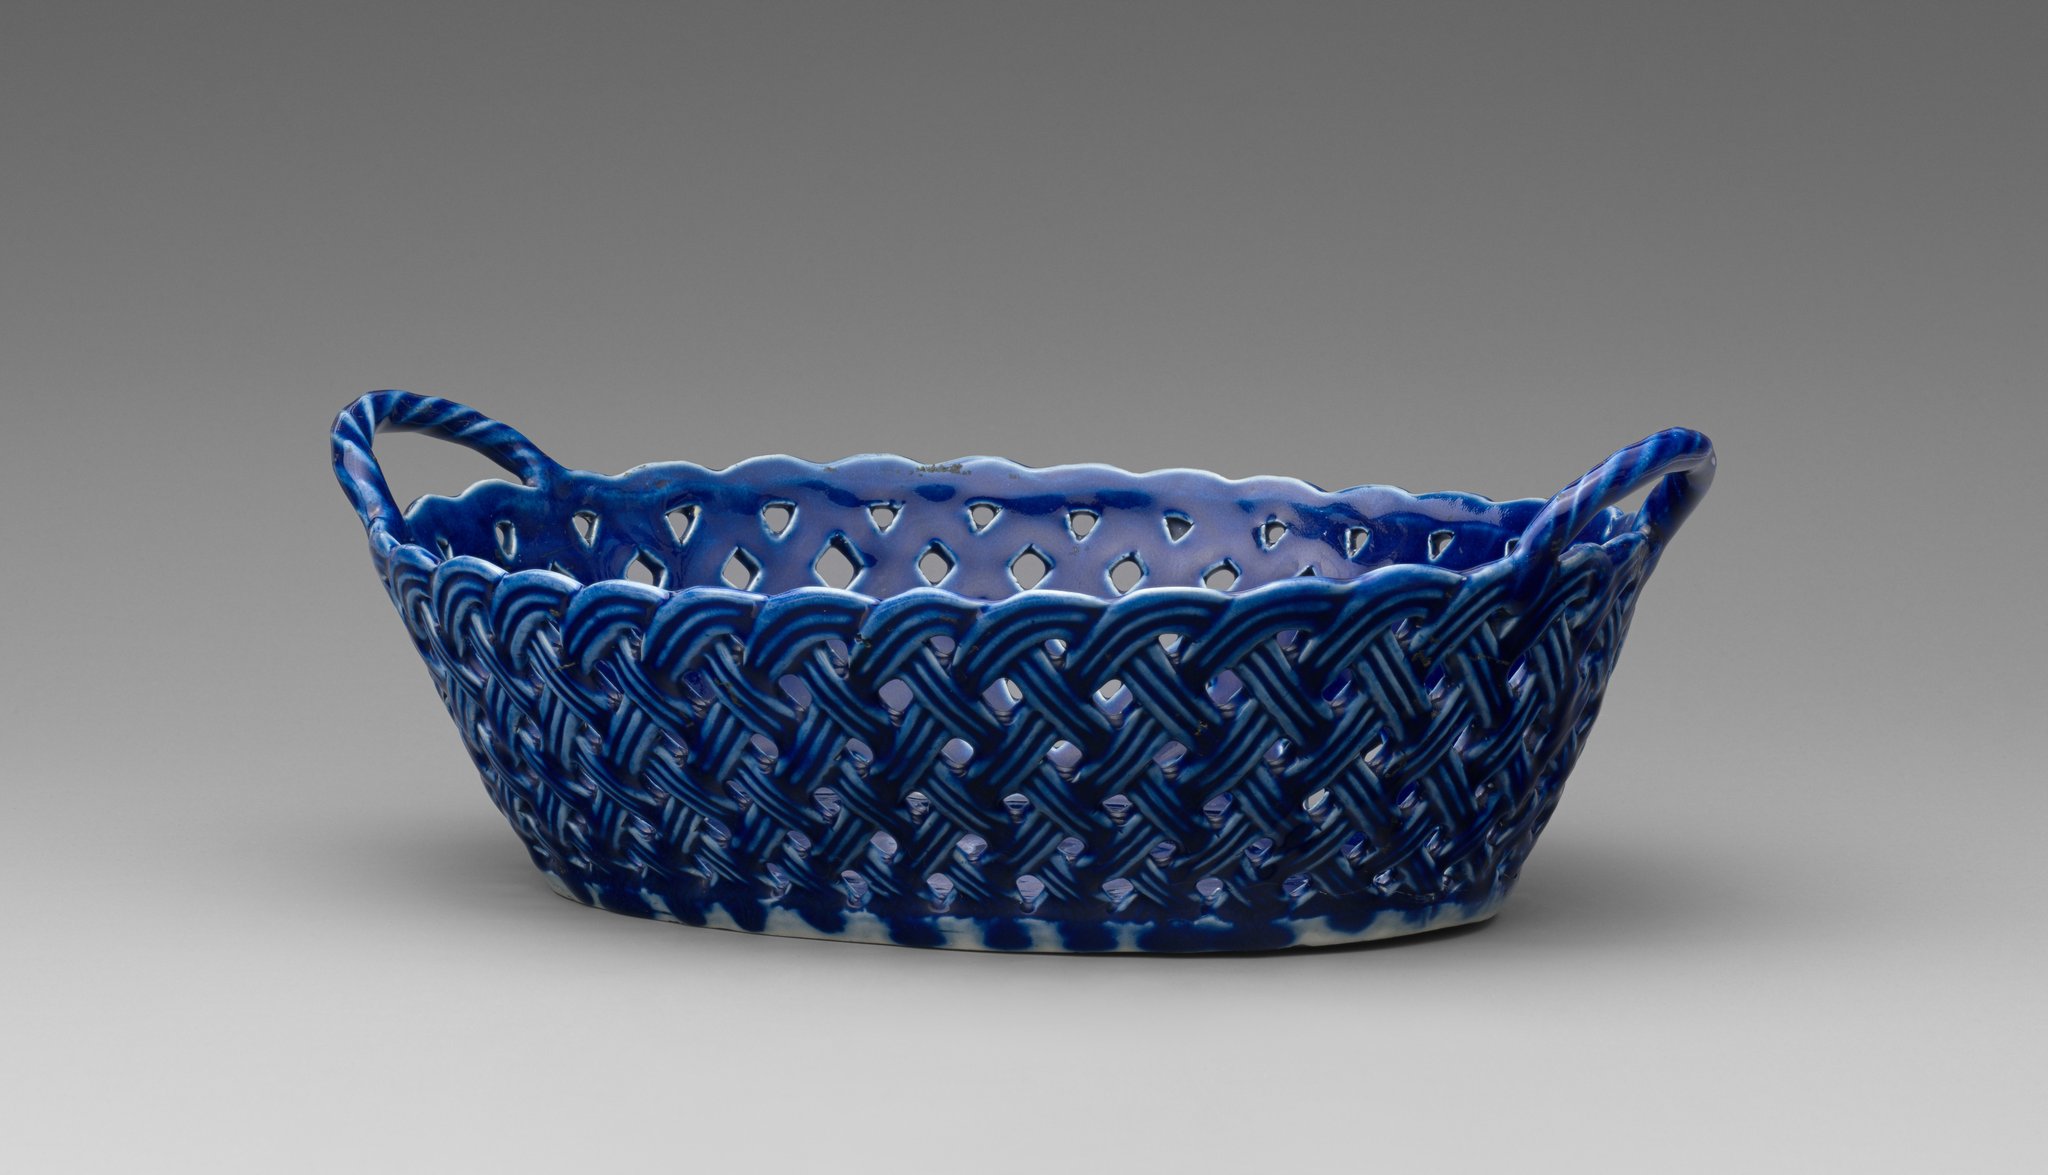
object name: basket dish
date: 1755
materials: stoneware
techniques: salt glaze